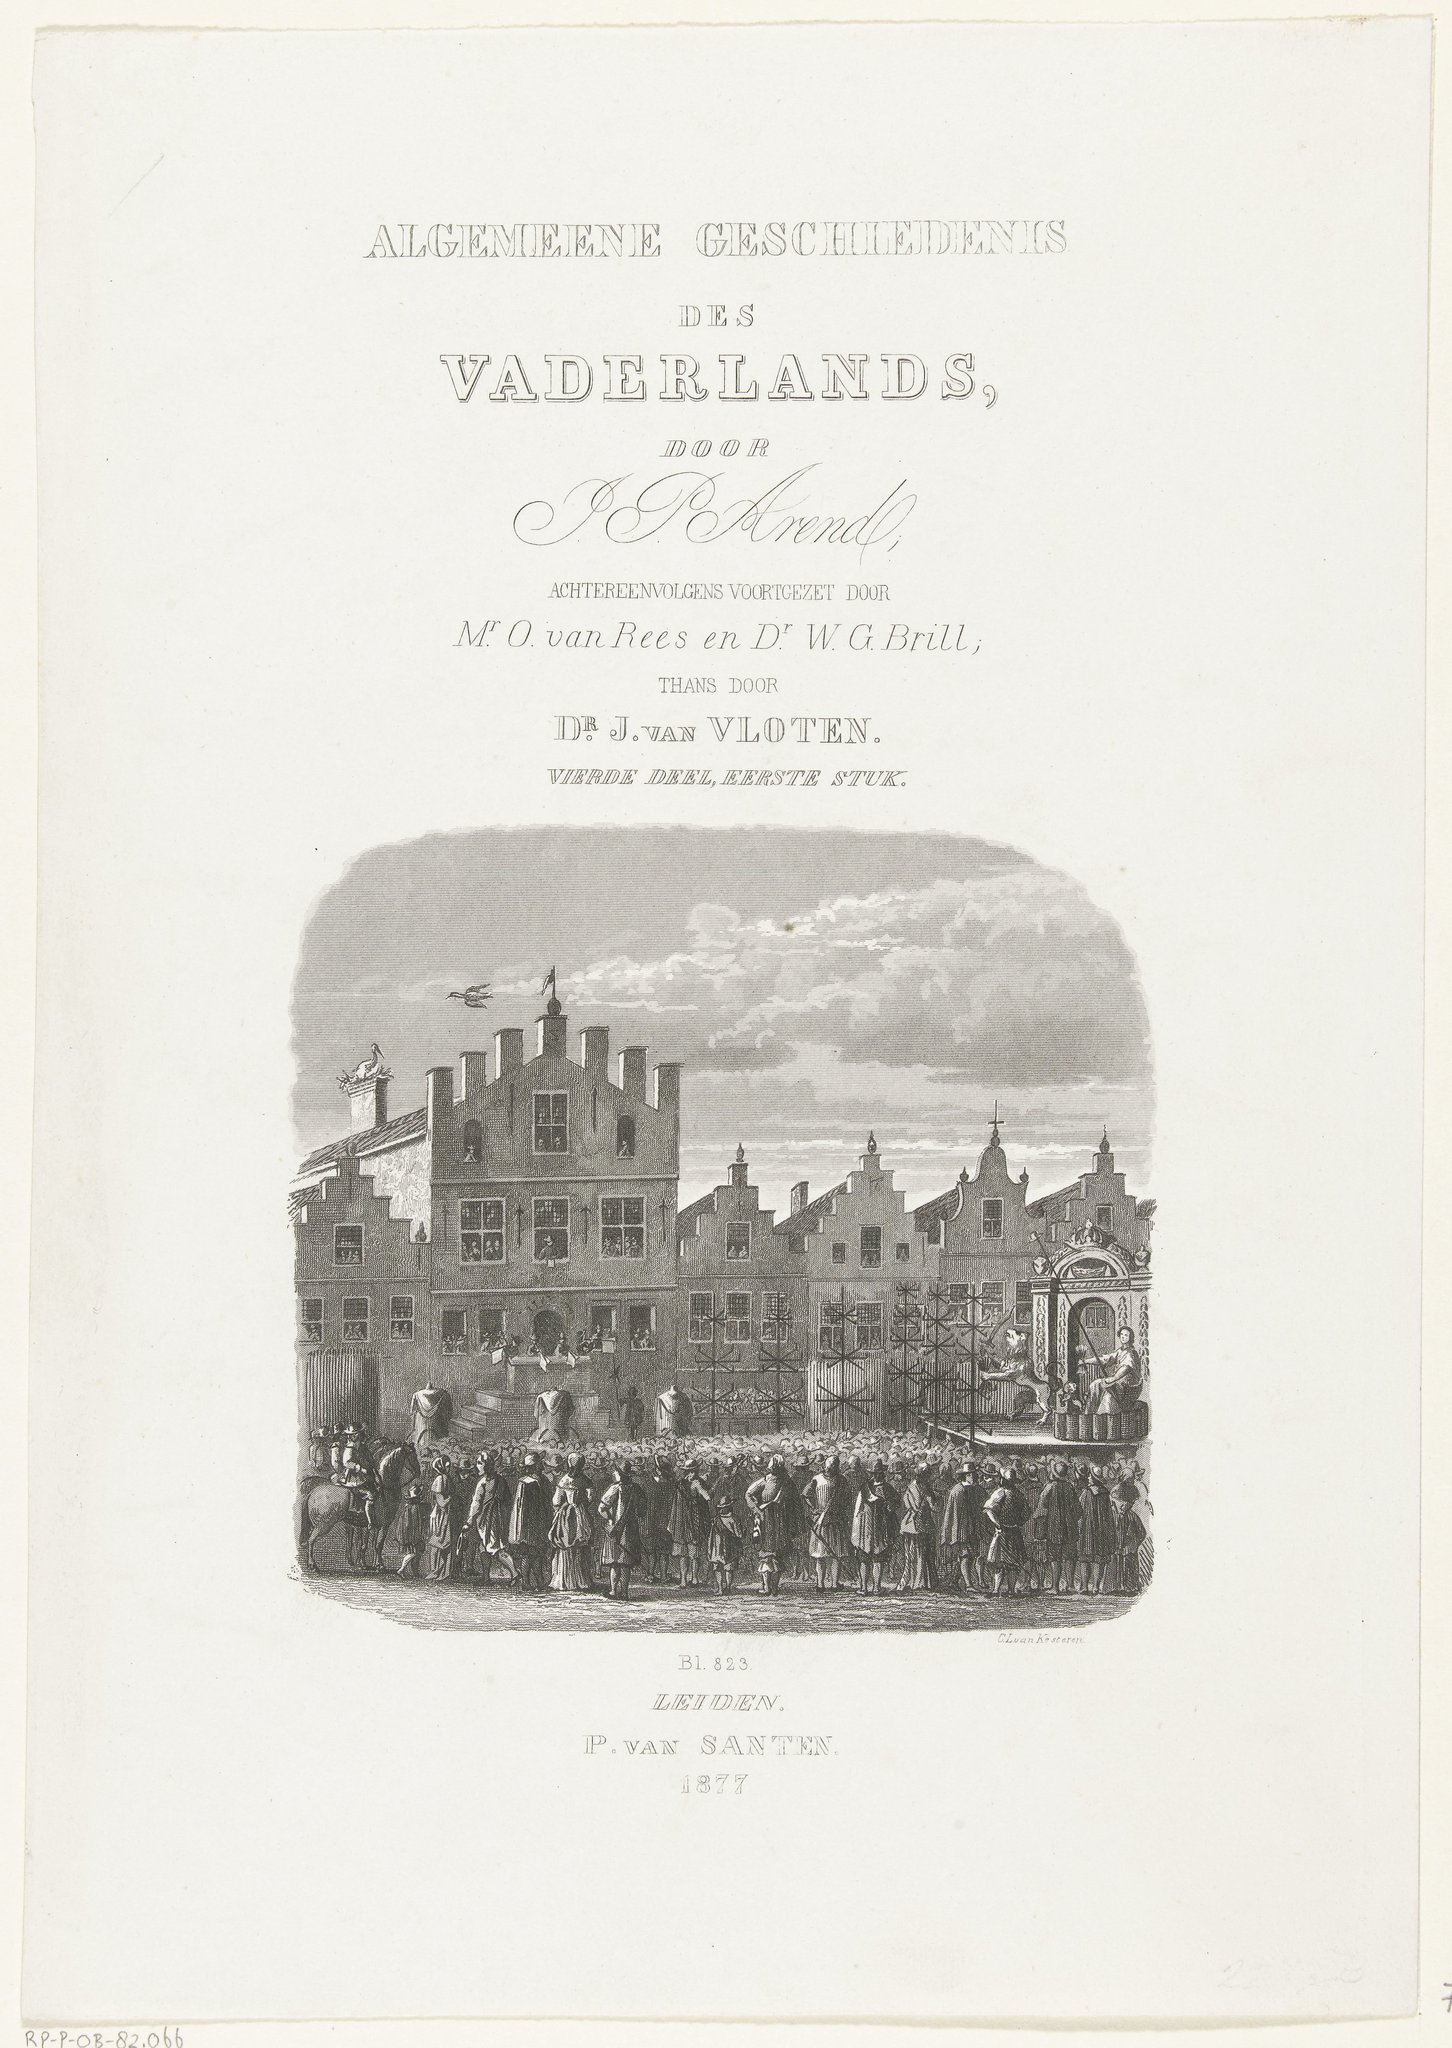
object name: history print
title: Bekendmaking van de Vrede van Breda, 1667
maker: christiaan lodewijk van kesteren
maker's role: print maker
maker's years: 1832-1897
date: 1877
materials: paper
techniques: engraving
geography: netherlands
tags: proclamation of peace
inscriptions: date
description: Gebruikt als illustratie in: J.P. Arend, Algemeene geschiedenis des vaderlands, voortgezet door O. van Rees, W.G. Brille en J. van Vloten, Amsterdam, 5 delen, 1840-1882, dl. 4.1 (1879), titelpagina.